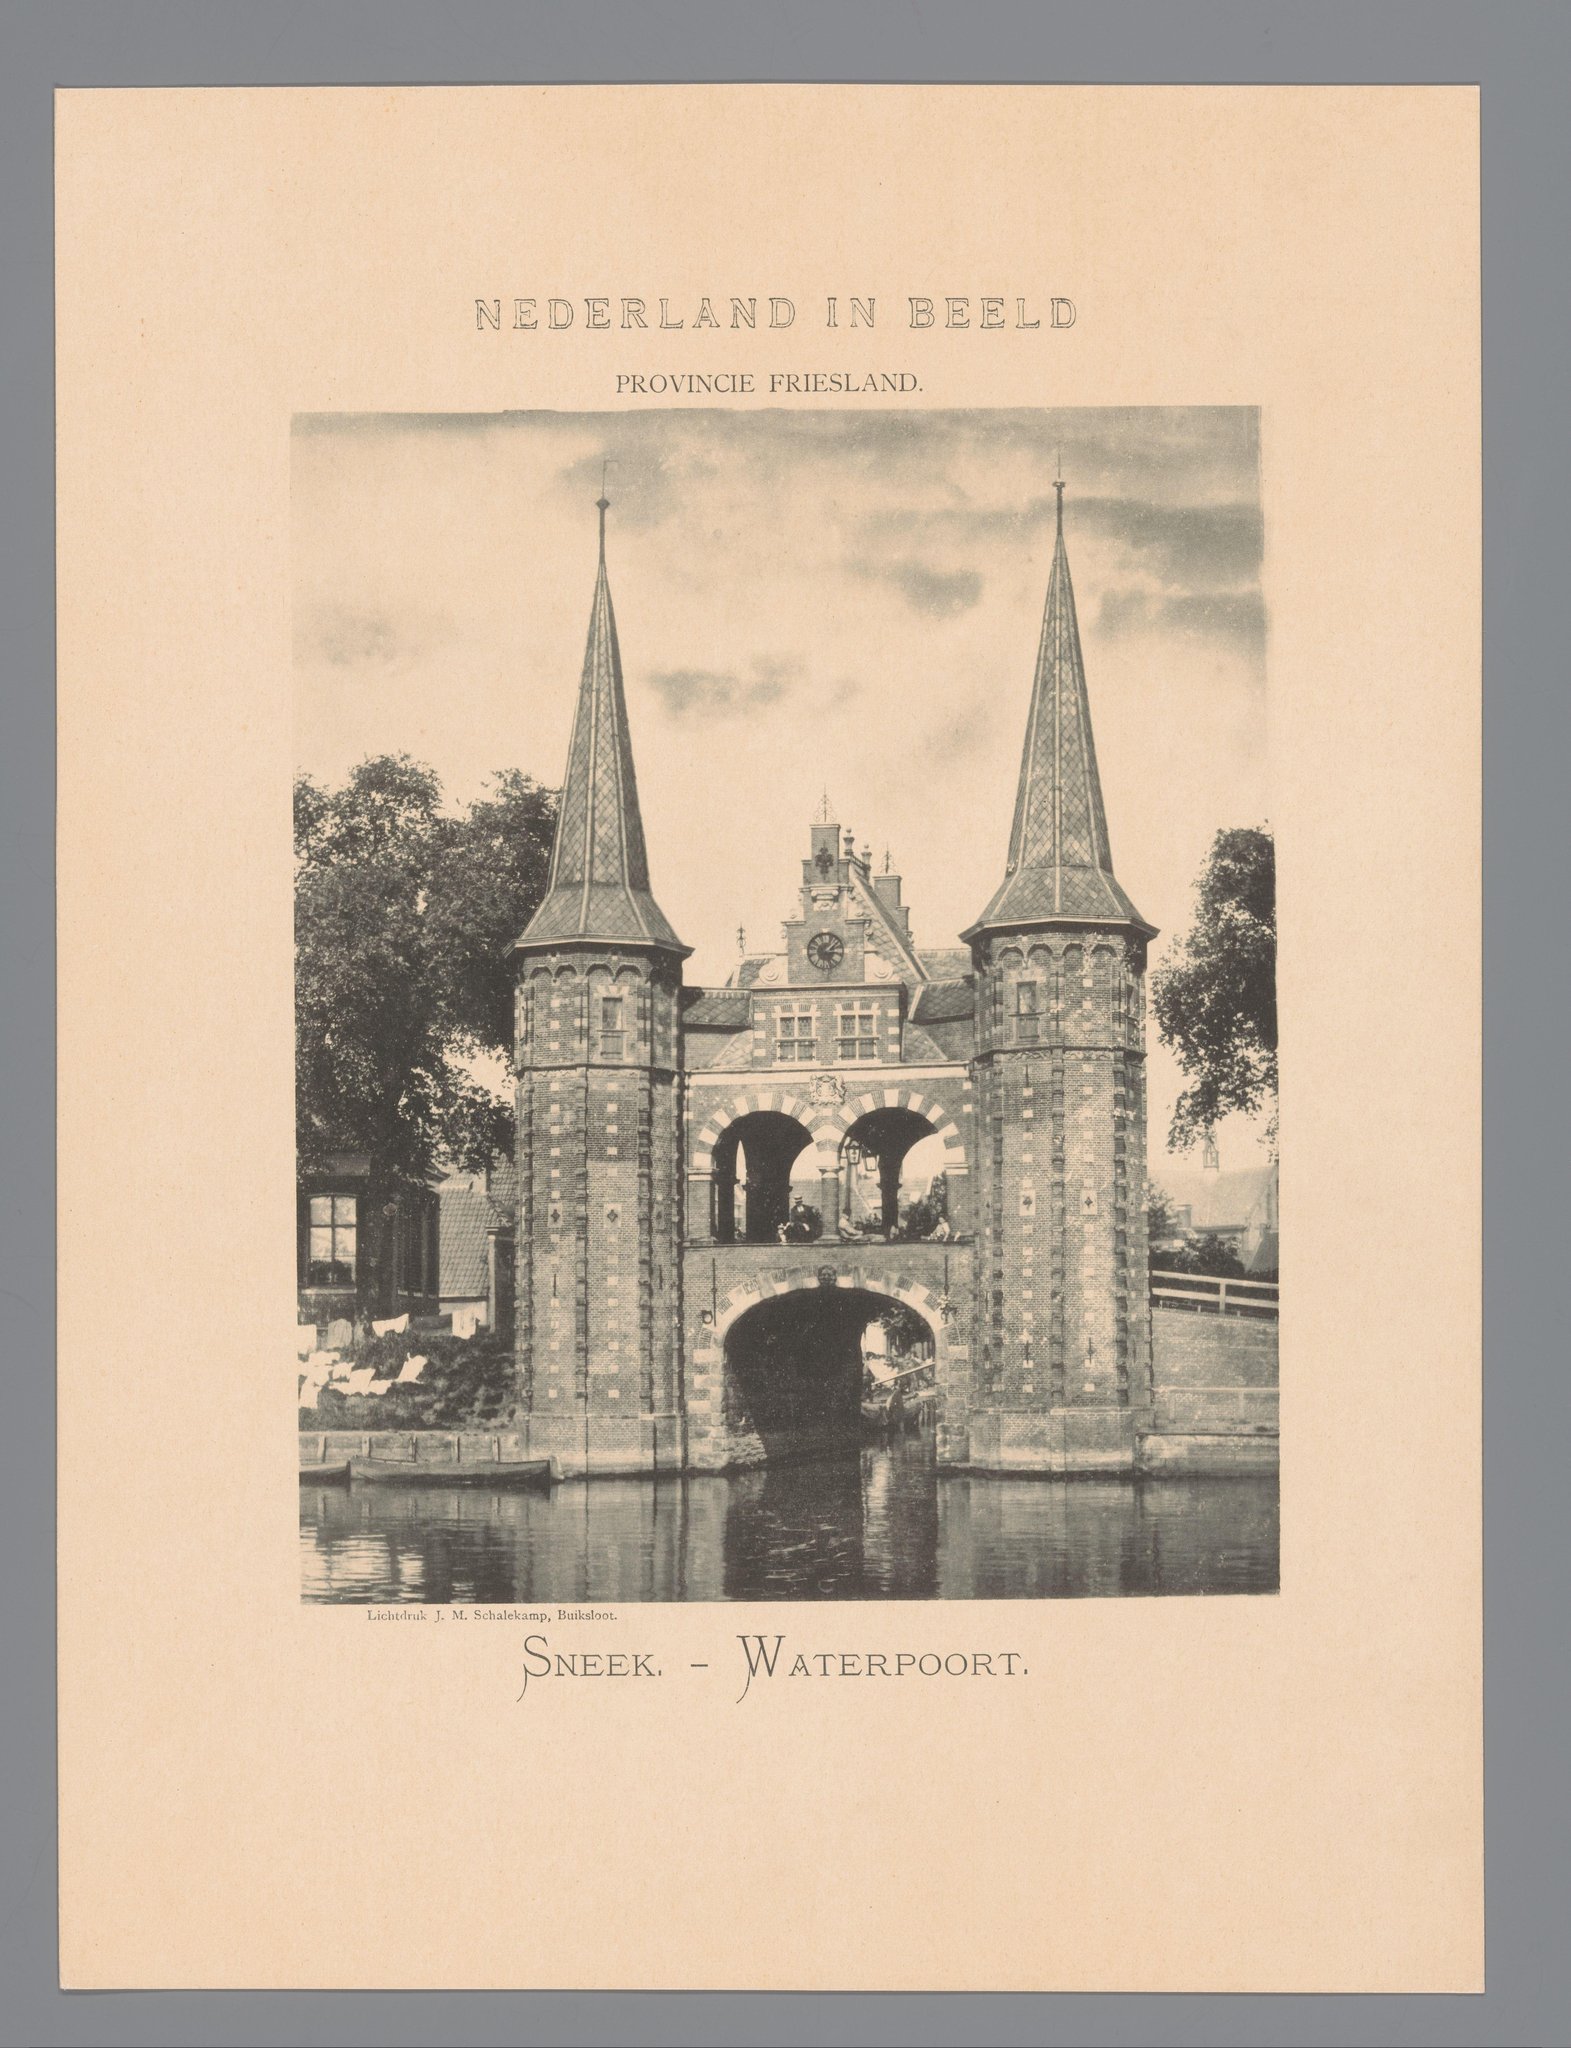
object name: photomechanical print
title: Gezicht op de Waterpoort te Sneek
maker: johan marinus schalekamp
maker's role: publisher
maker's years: 1844-1912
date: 1896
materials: paper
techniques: photograph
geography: buiksloot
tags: bridge with structure, i.e. cover or buildings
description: Afdruk uit: Nederland in Beeld. Buiksloot: J.M. Schalekamp, 1896.